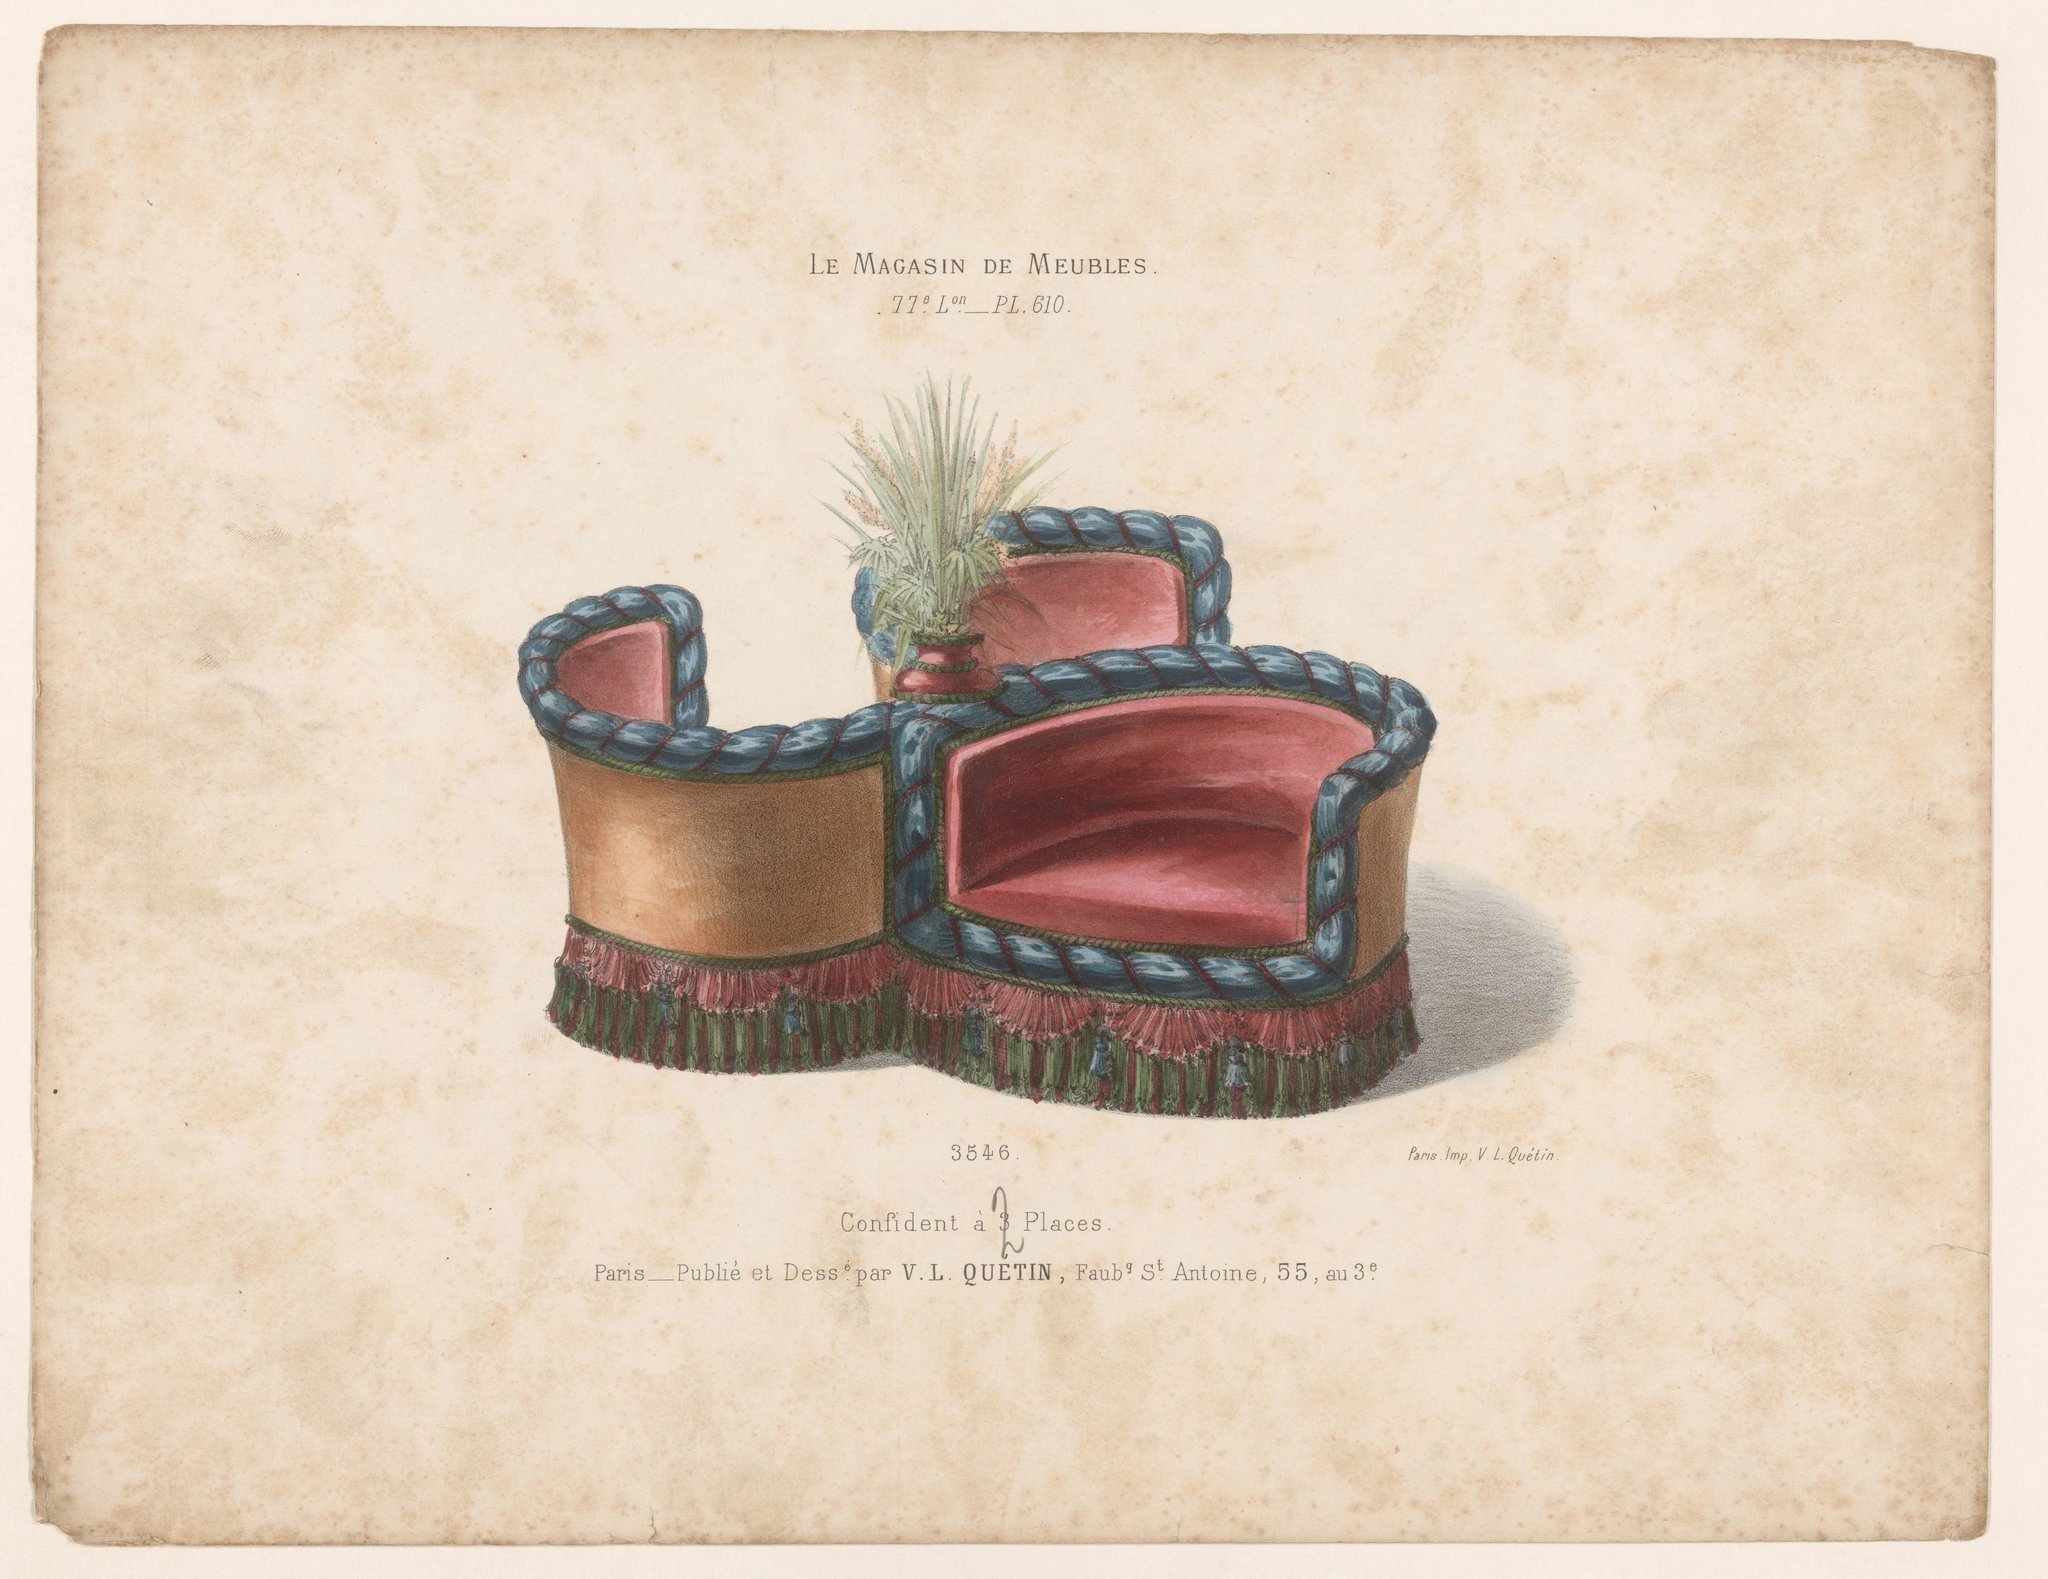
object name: print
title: Le Magasin de Meubles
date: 1878-1904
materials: paper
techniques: hand coloring, lithograph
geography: paris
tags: seating furniture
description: Een ronde confident (drie zitplaatsen naar elkaar waarbij men in tegenovergestelde richting kijkt). Prent uit 77e Livraison.